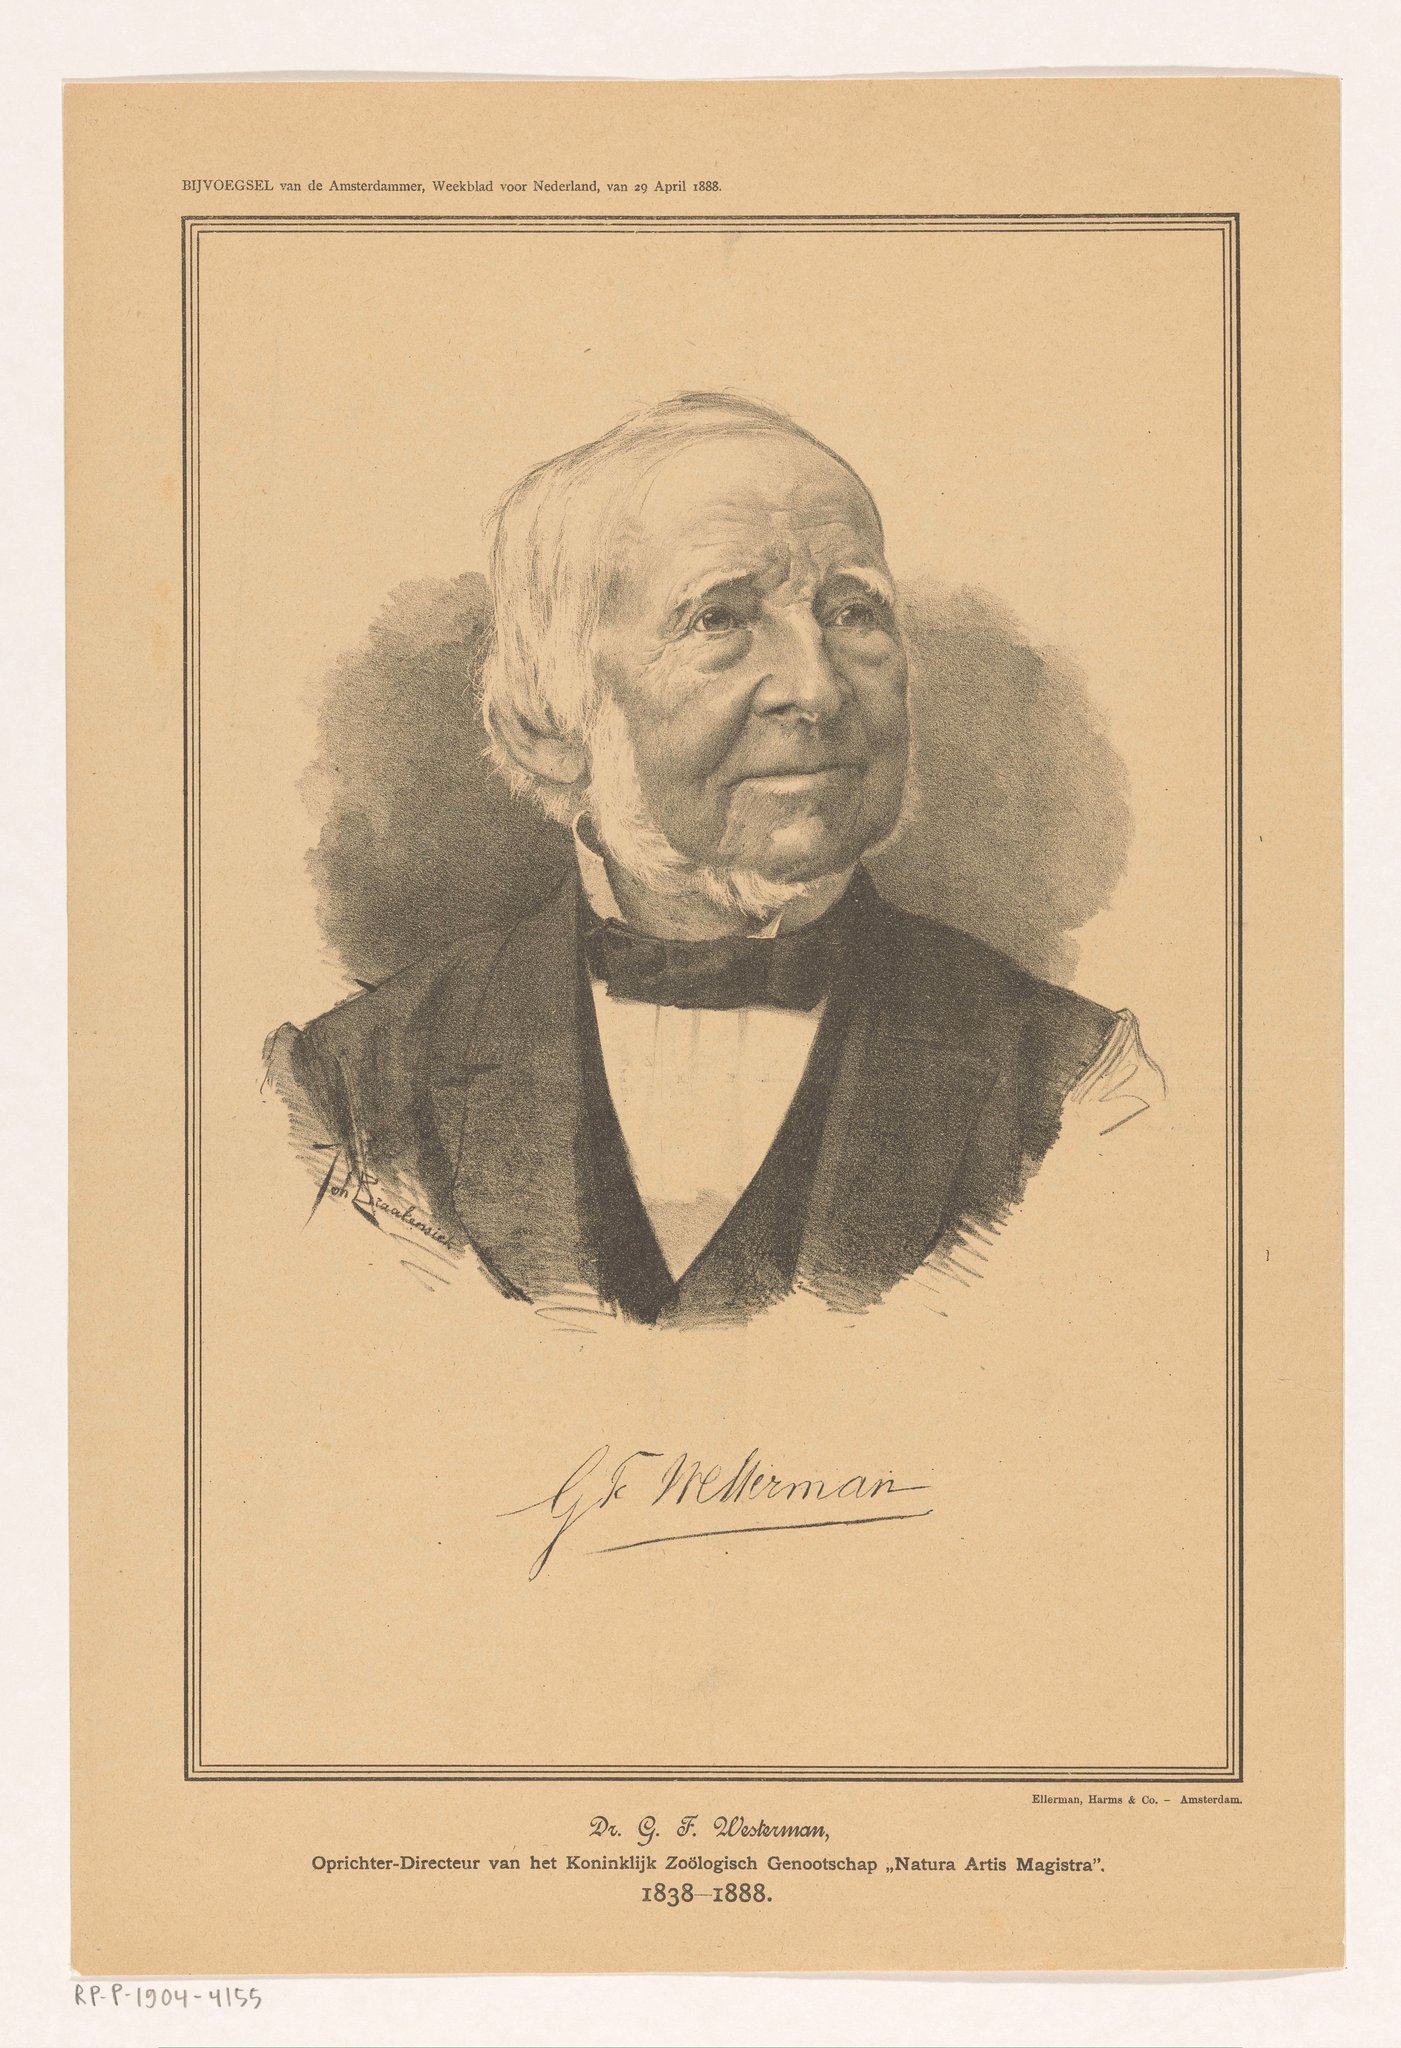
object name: print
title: Dr. G.F. Westerman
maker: johan braakensiek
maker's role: draughtsman, print maker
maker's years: 1858-1940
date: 1888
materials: paper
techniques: lithograph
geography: amsterdam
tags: rotterdam, gerardus frederik westerman, historical persons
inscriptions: collector's mark: Lugt 2228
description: Portret van Gerardus Frederik Westerman, één van de drie oprichters van het Koninklijk Zoölogisch Genootschap Natura Artis Magistra.